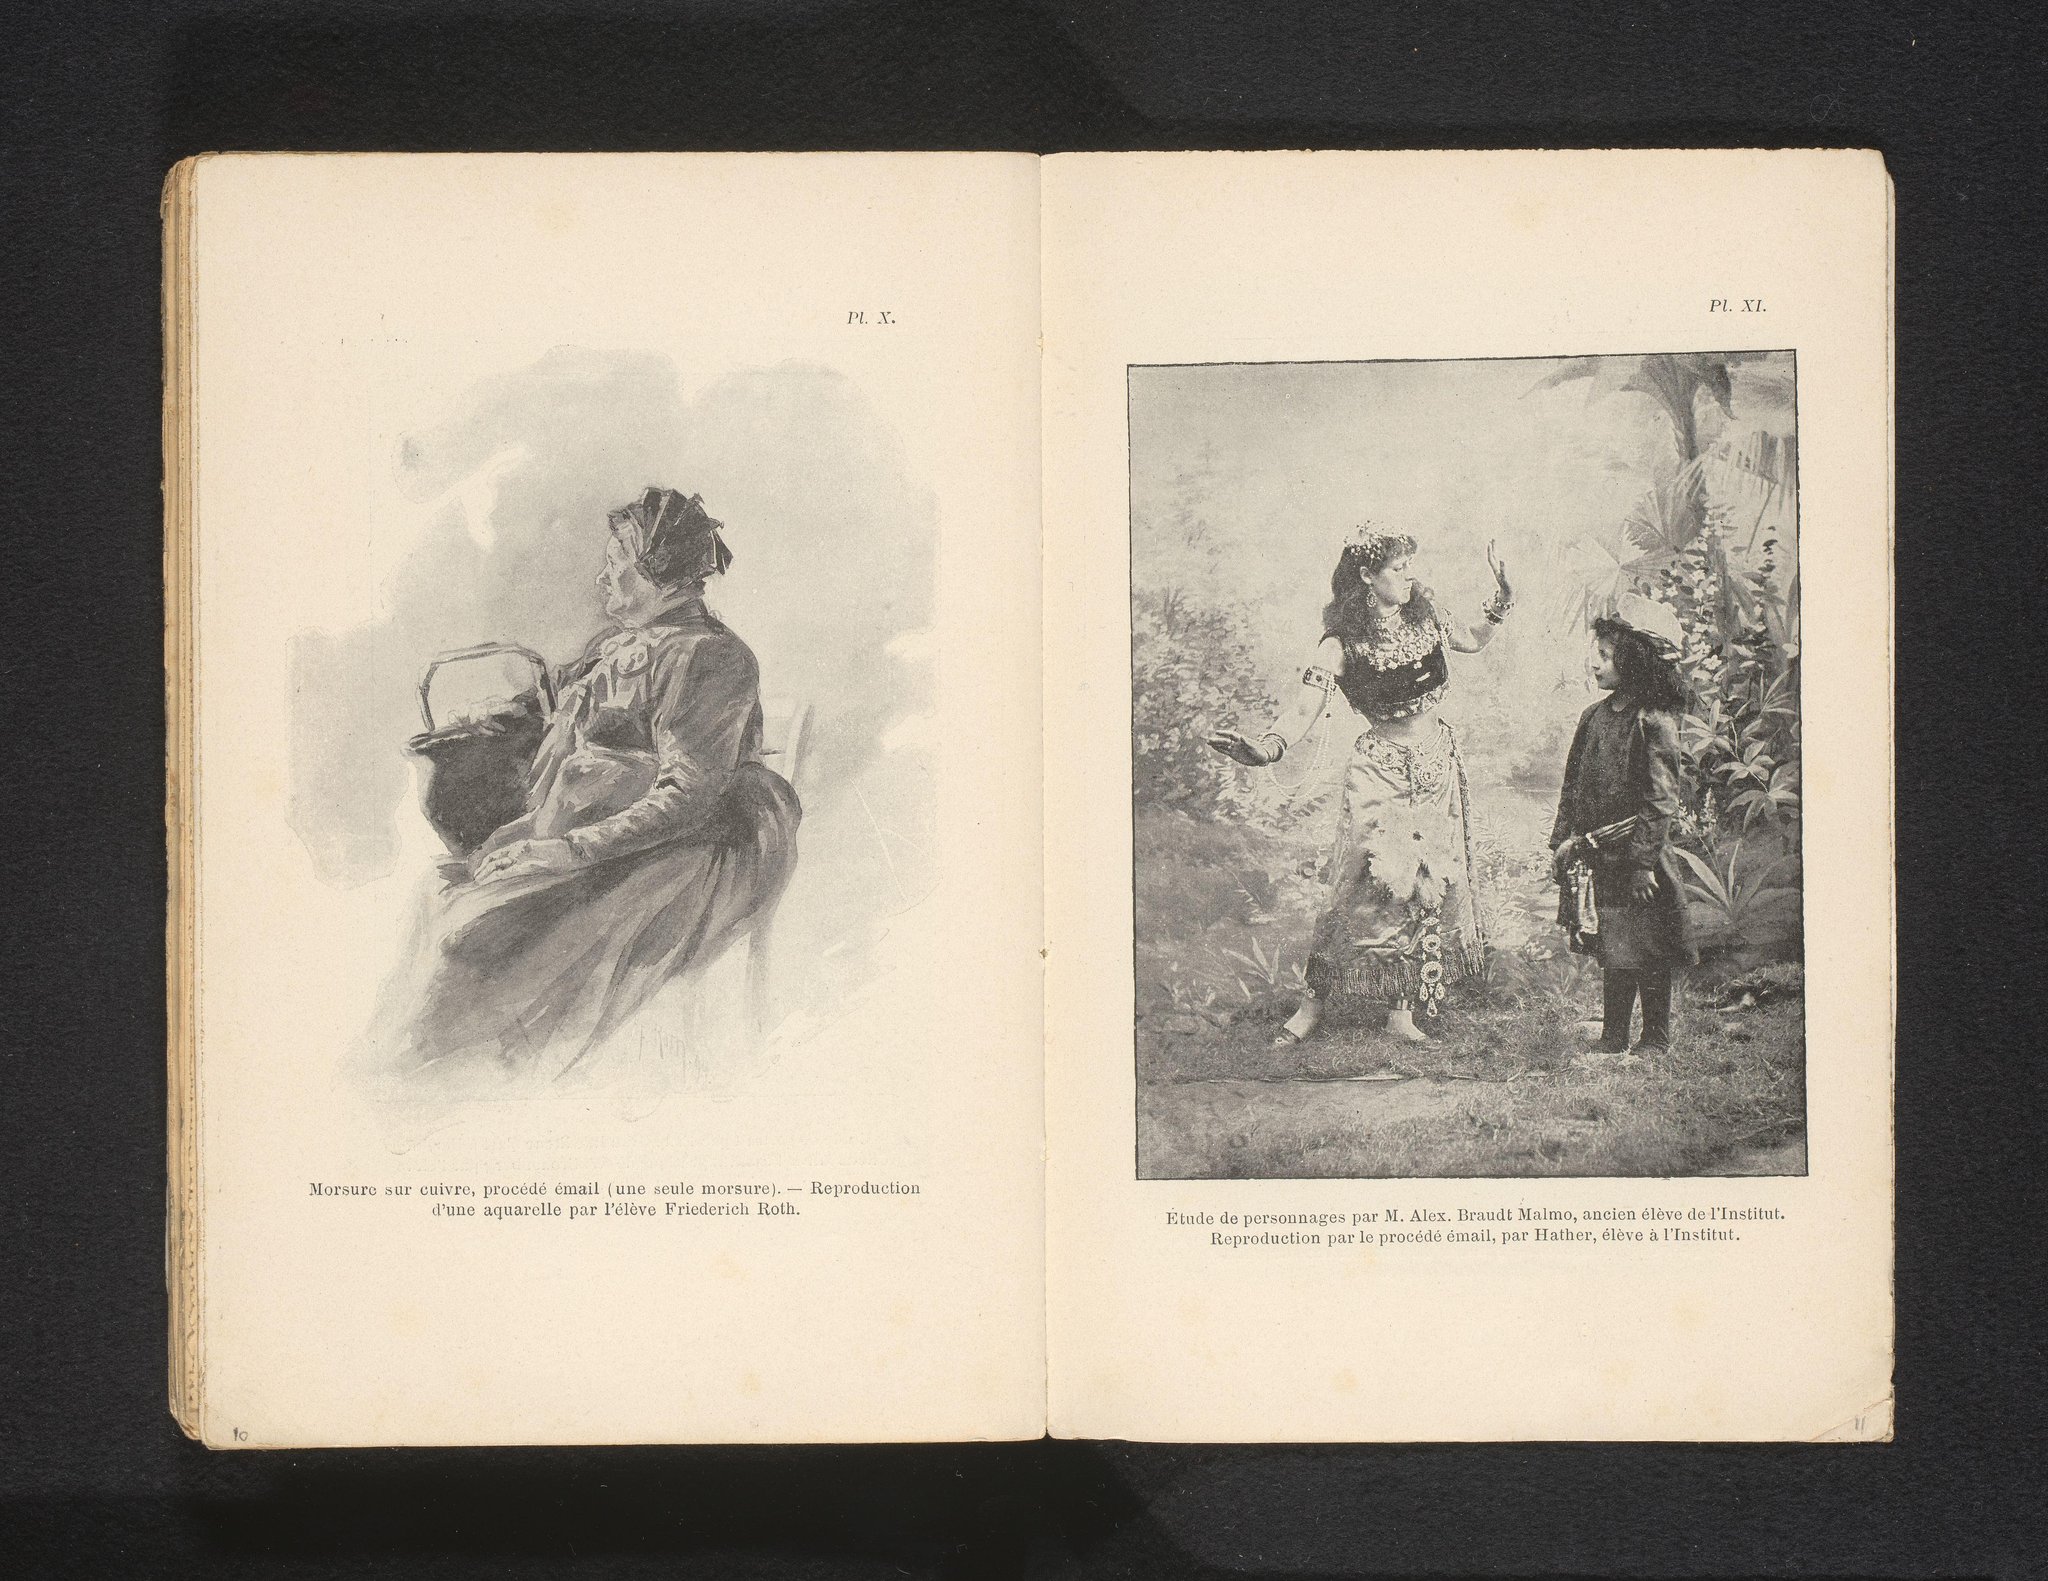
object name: page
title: Étude de personnages par M. Alex. Braudt Malmo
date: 1888-1898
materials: paper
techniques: autotype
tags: studio requisites ~ photographer, fantasy costume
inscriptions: number: ‘Pl. XI.’, inscription: ‘élève à l'Institut.’